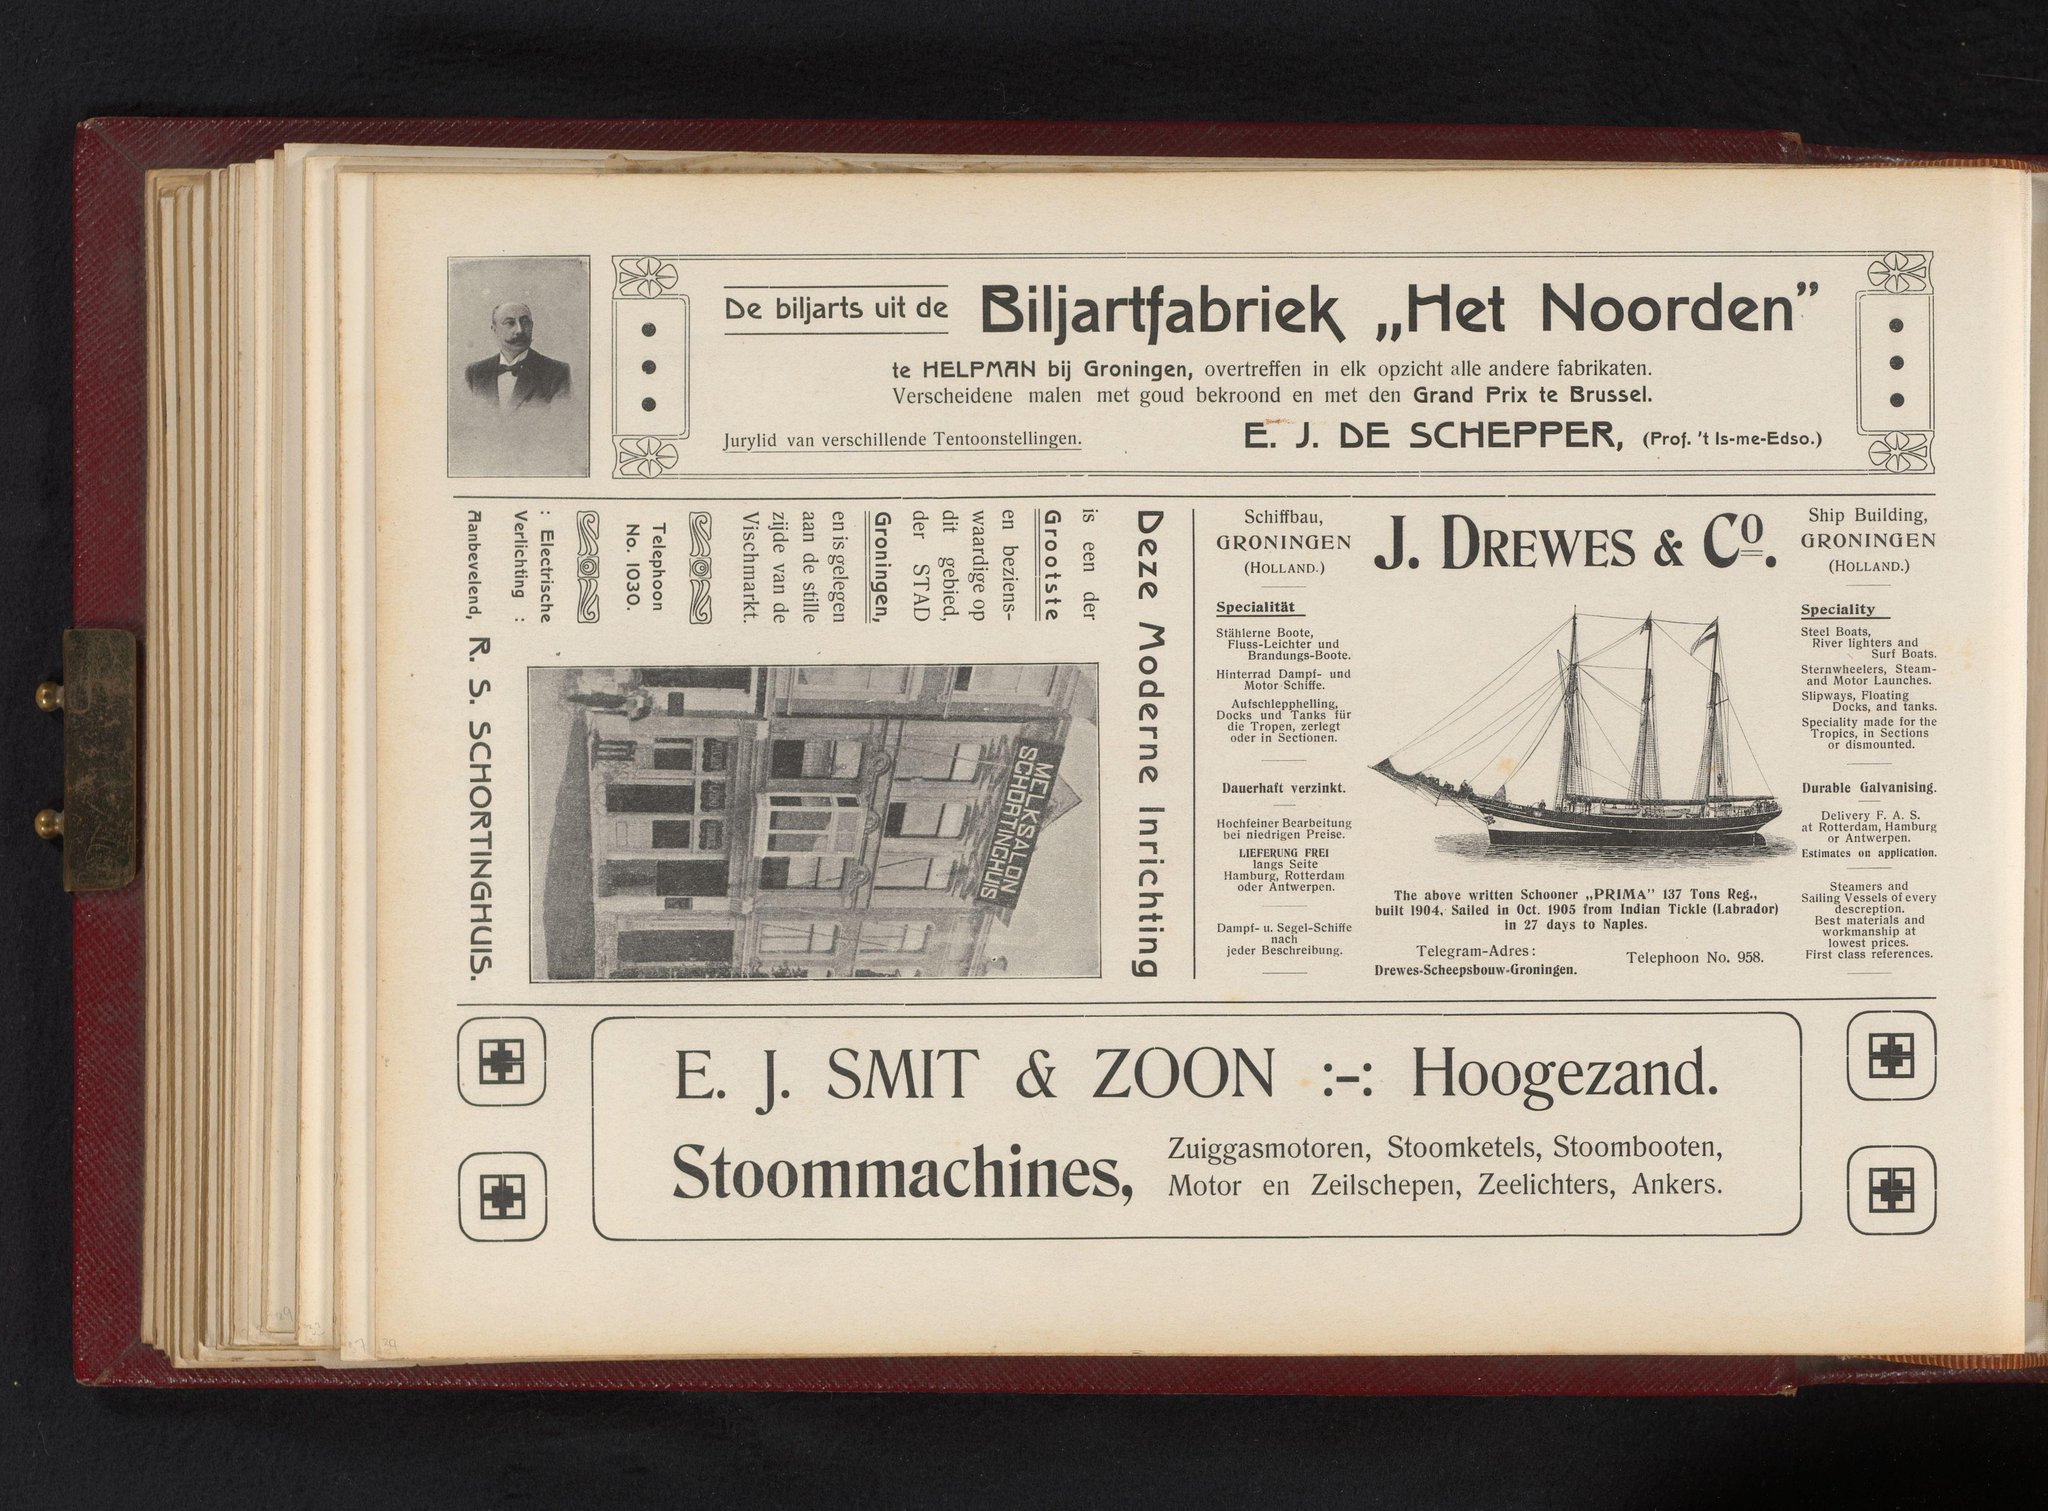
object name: album leaf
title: Advertenties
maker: Anonymous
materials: paper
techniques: printing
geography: netherlands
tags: advertising, historical persons, front façade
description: Advertenties voor onder andere Biljartfabriek Het Noorden, R.S. Schortinghuis, J. Drewes & Co. en E. J. Smit & Zoon. Bij enkele advertenties is een autotypie geplaatst. Deze pagina maakt deel uit van een album.